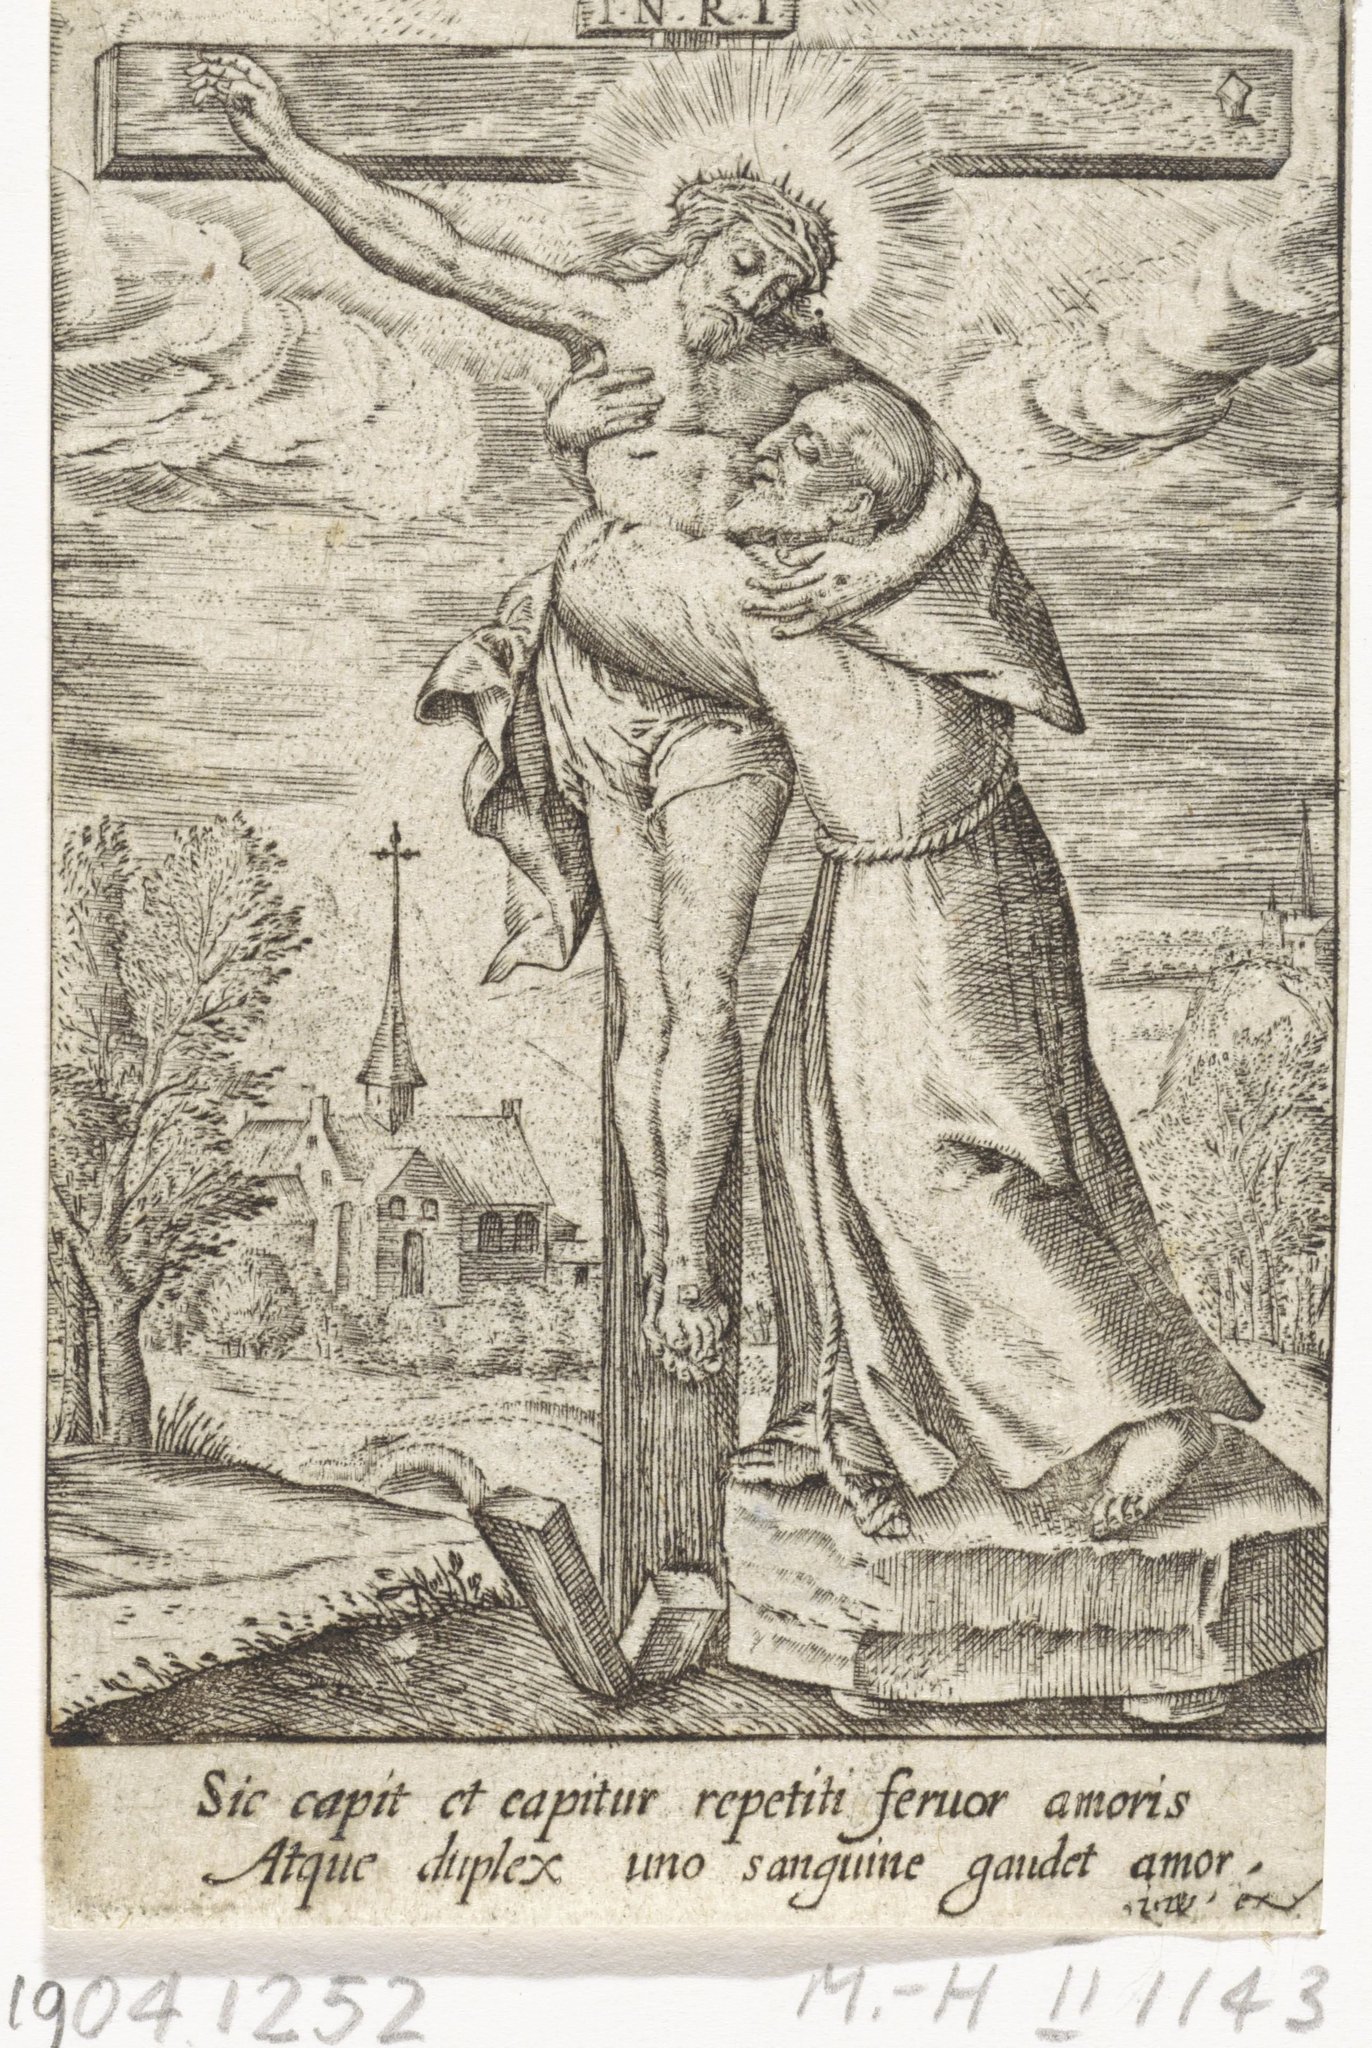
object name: print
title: H. Franciscus van Assisi omhelst Christus aan het kruis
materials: paper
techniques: engraving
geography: antwerp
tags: st. francis of assisi embracing christ on the cross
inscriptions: collector's mark: 2228, caption: ‘Sic capit et capitur [...] gaudet amor.’ Lugt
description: De heilige Franciscus van Assisi omhelst Christus aan het kruis. Christus beantwoordt de omhelzing en slaat zijn arm om de heilige. Op de achtergrond een kerk. In de marge een tweeregelig onderschrift in het Latijn.